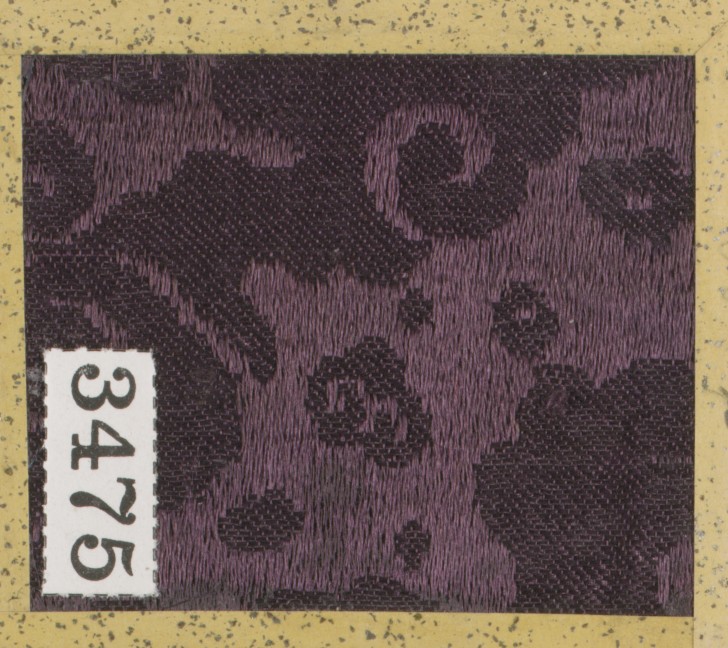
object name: sample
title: Textile Sample from Sample Book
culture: japanese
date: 1801-1900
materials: silk